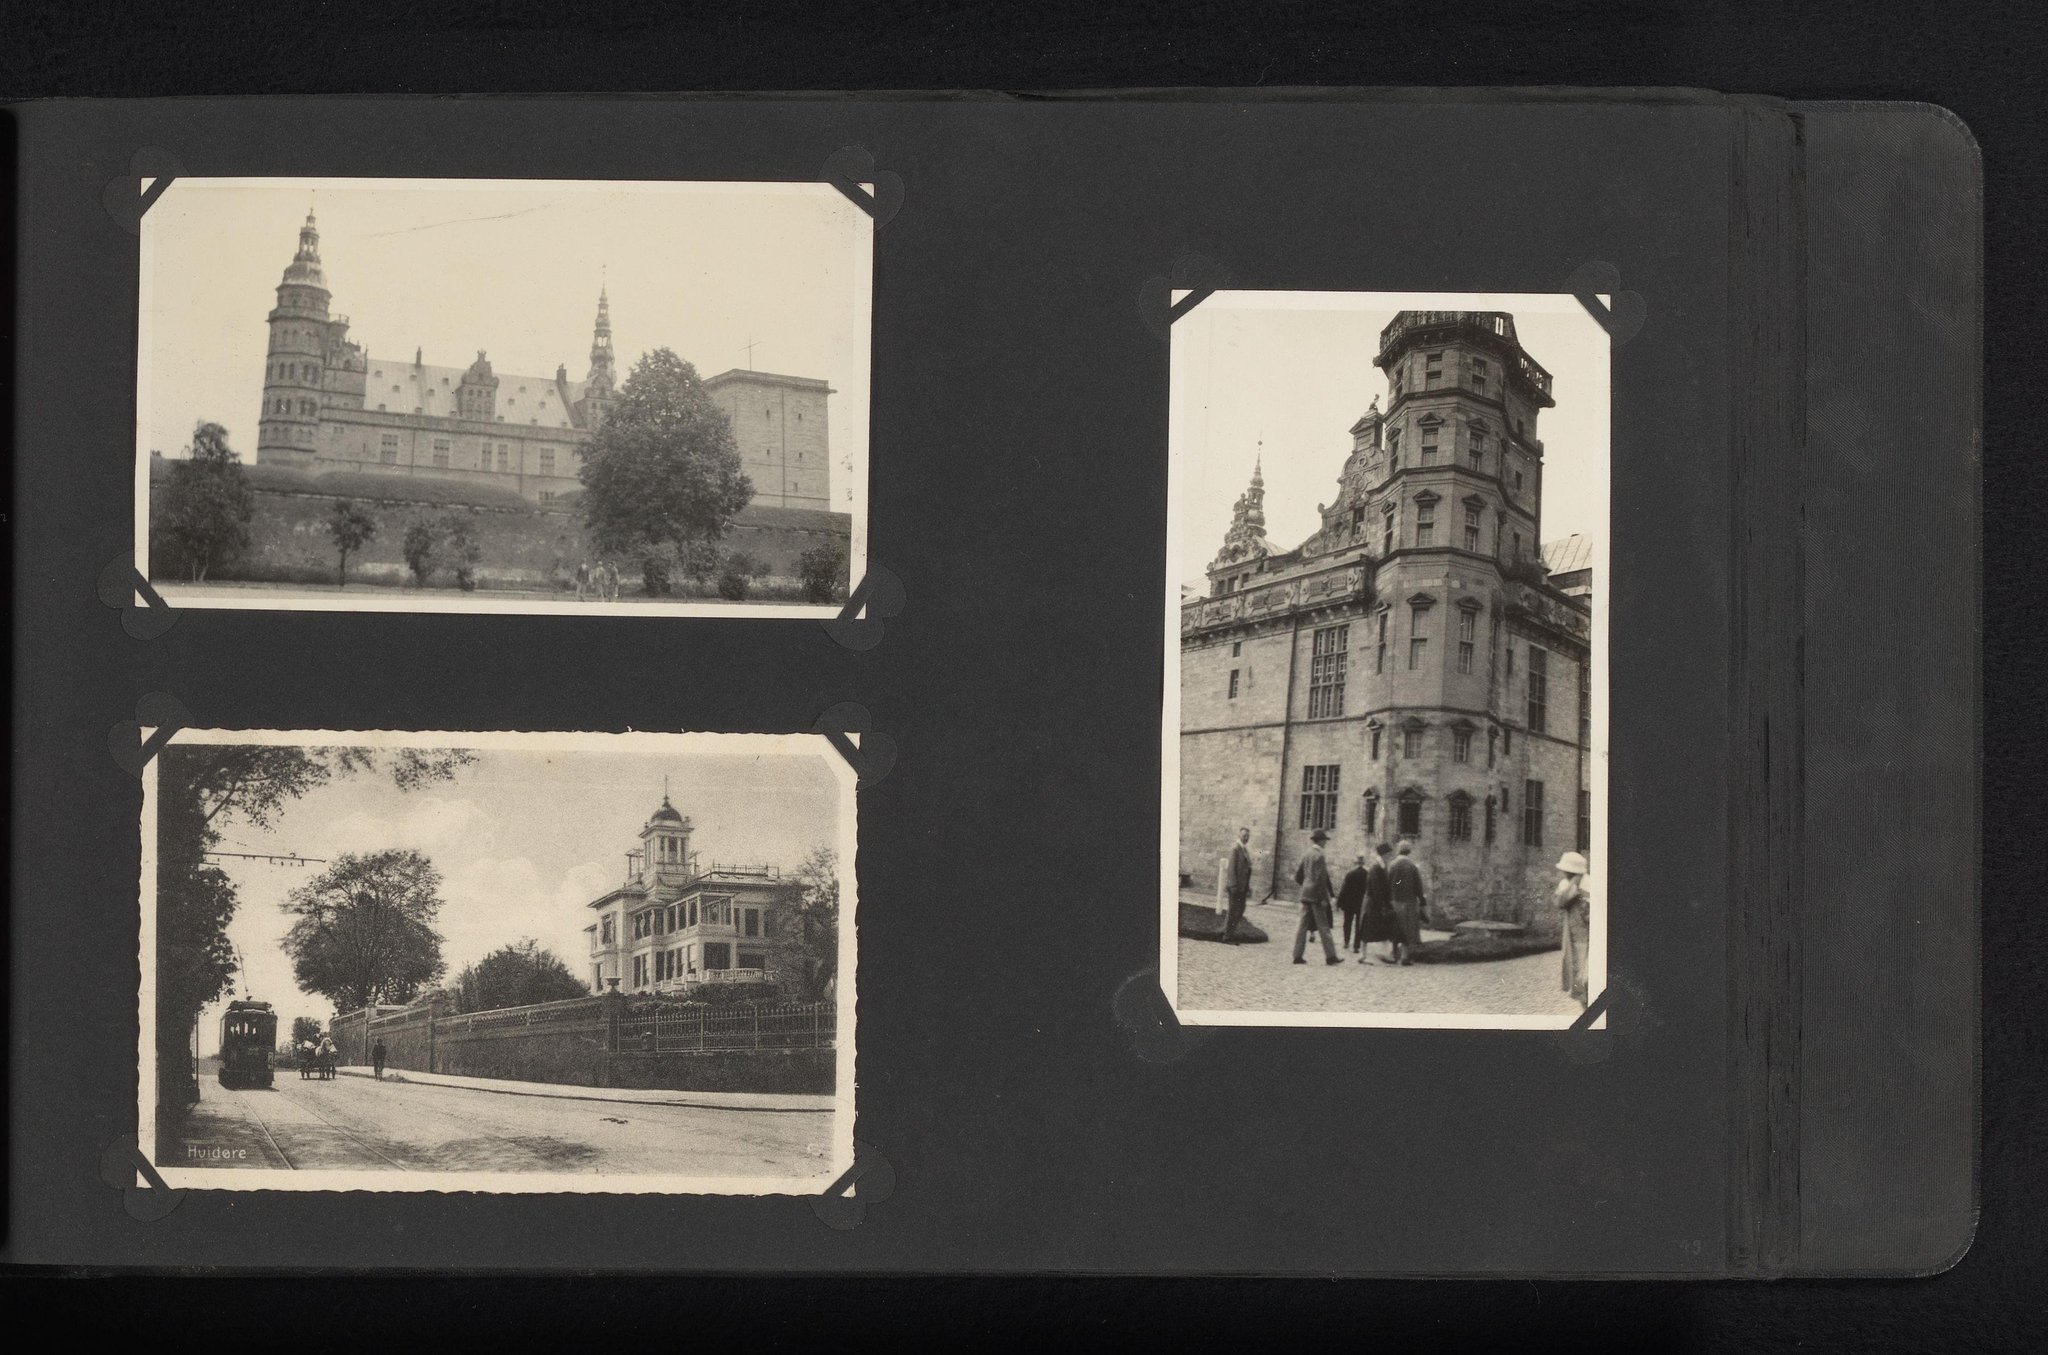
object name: photomechanical print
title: Twee foto's en een fotomechanische prentbriefkaart van kasteel Kronborg, Kopenhagen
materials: paper, cardboard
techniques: gelatin silver print, photolithography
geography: copenhagen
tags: castle, copenhagen (city)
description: Deze foto's en prent maken deel uit van een album.